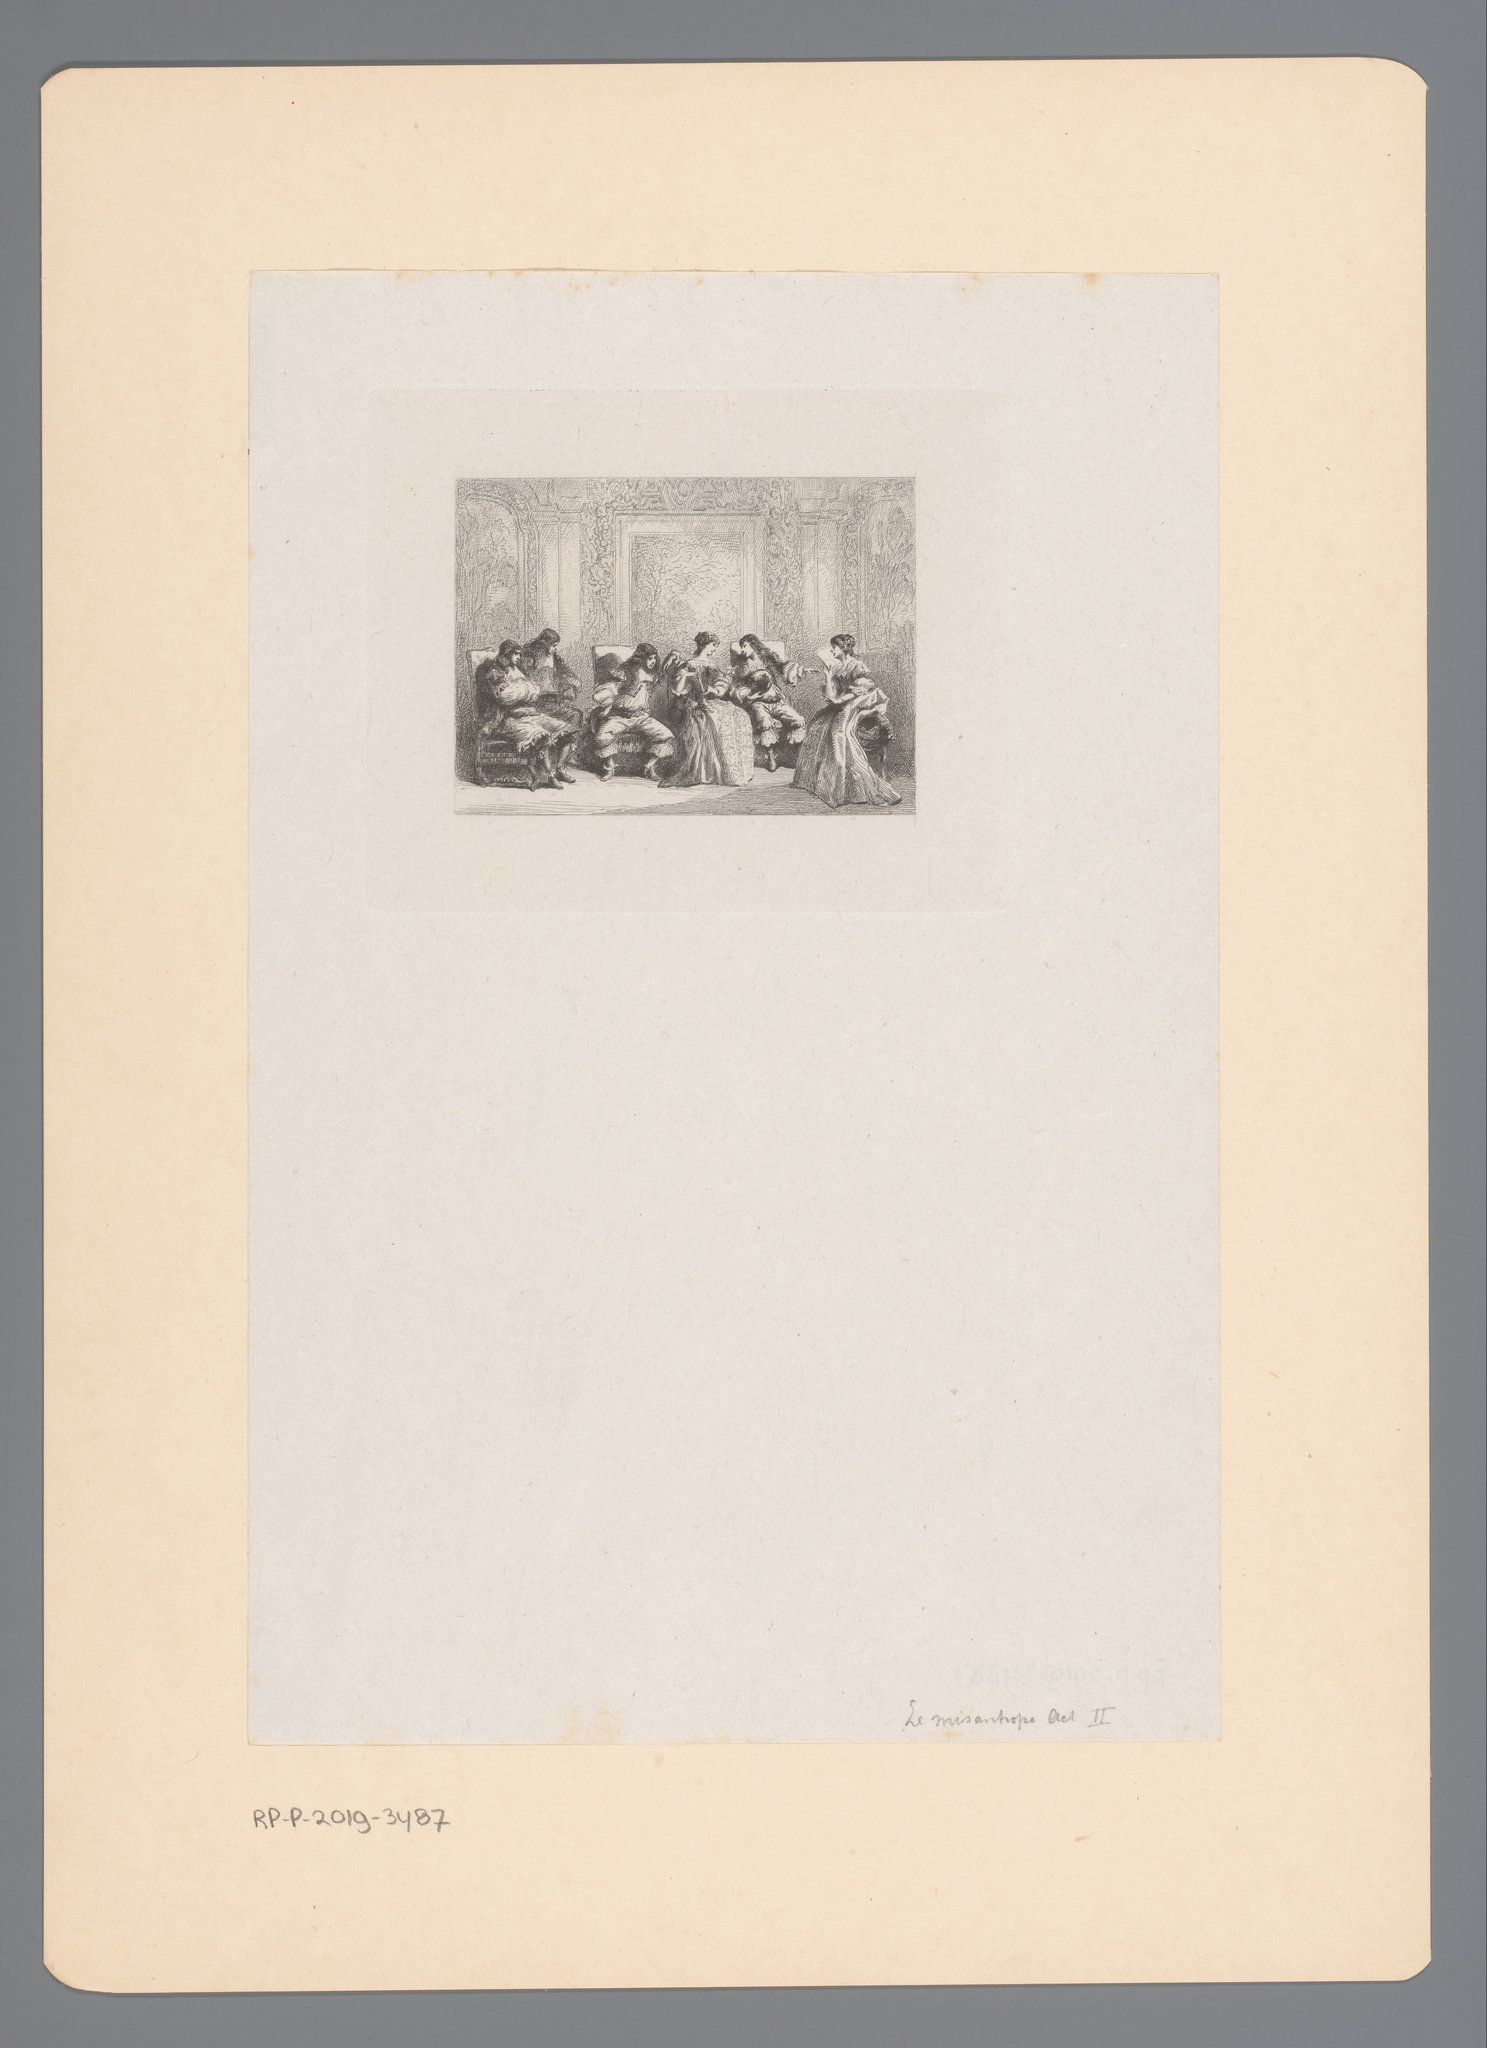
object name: print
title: Molière Théatre Choisi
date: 1878-1879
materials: paper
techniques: drypoint, etching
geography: tours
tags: theatre, theatrical performance, interior of the house, conversation, dialogue; conversation piece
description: Akte II, scène IV of V uit "Le Misanthrope" van Molière. Gezelschap in discussie, onder wie Alceste.